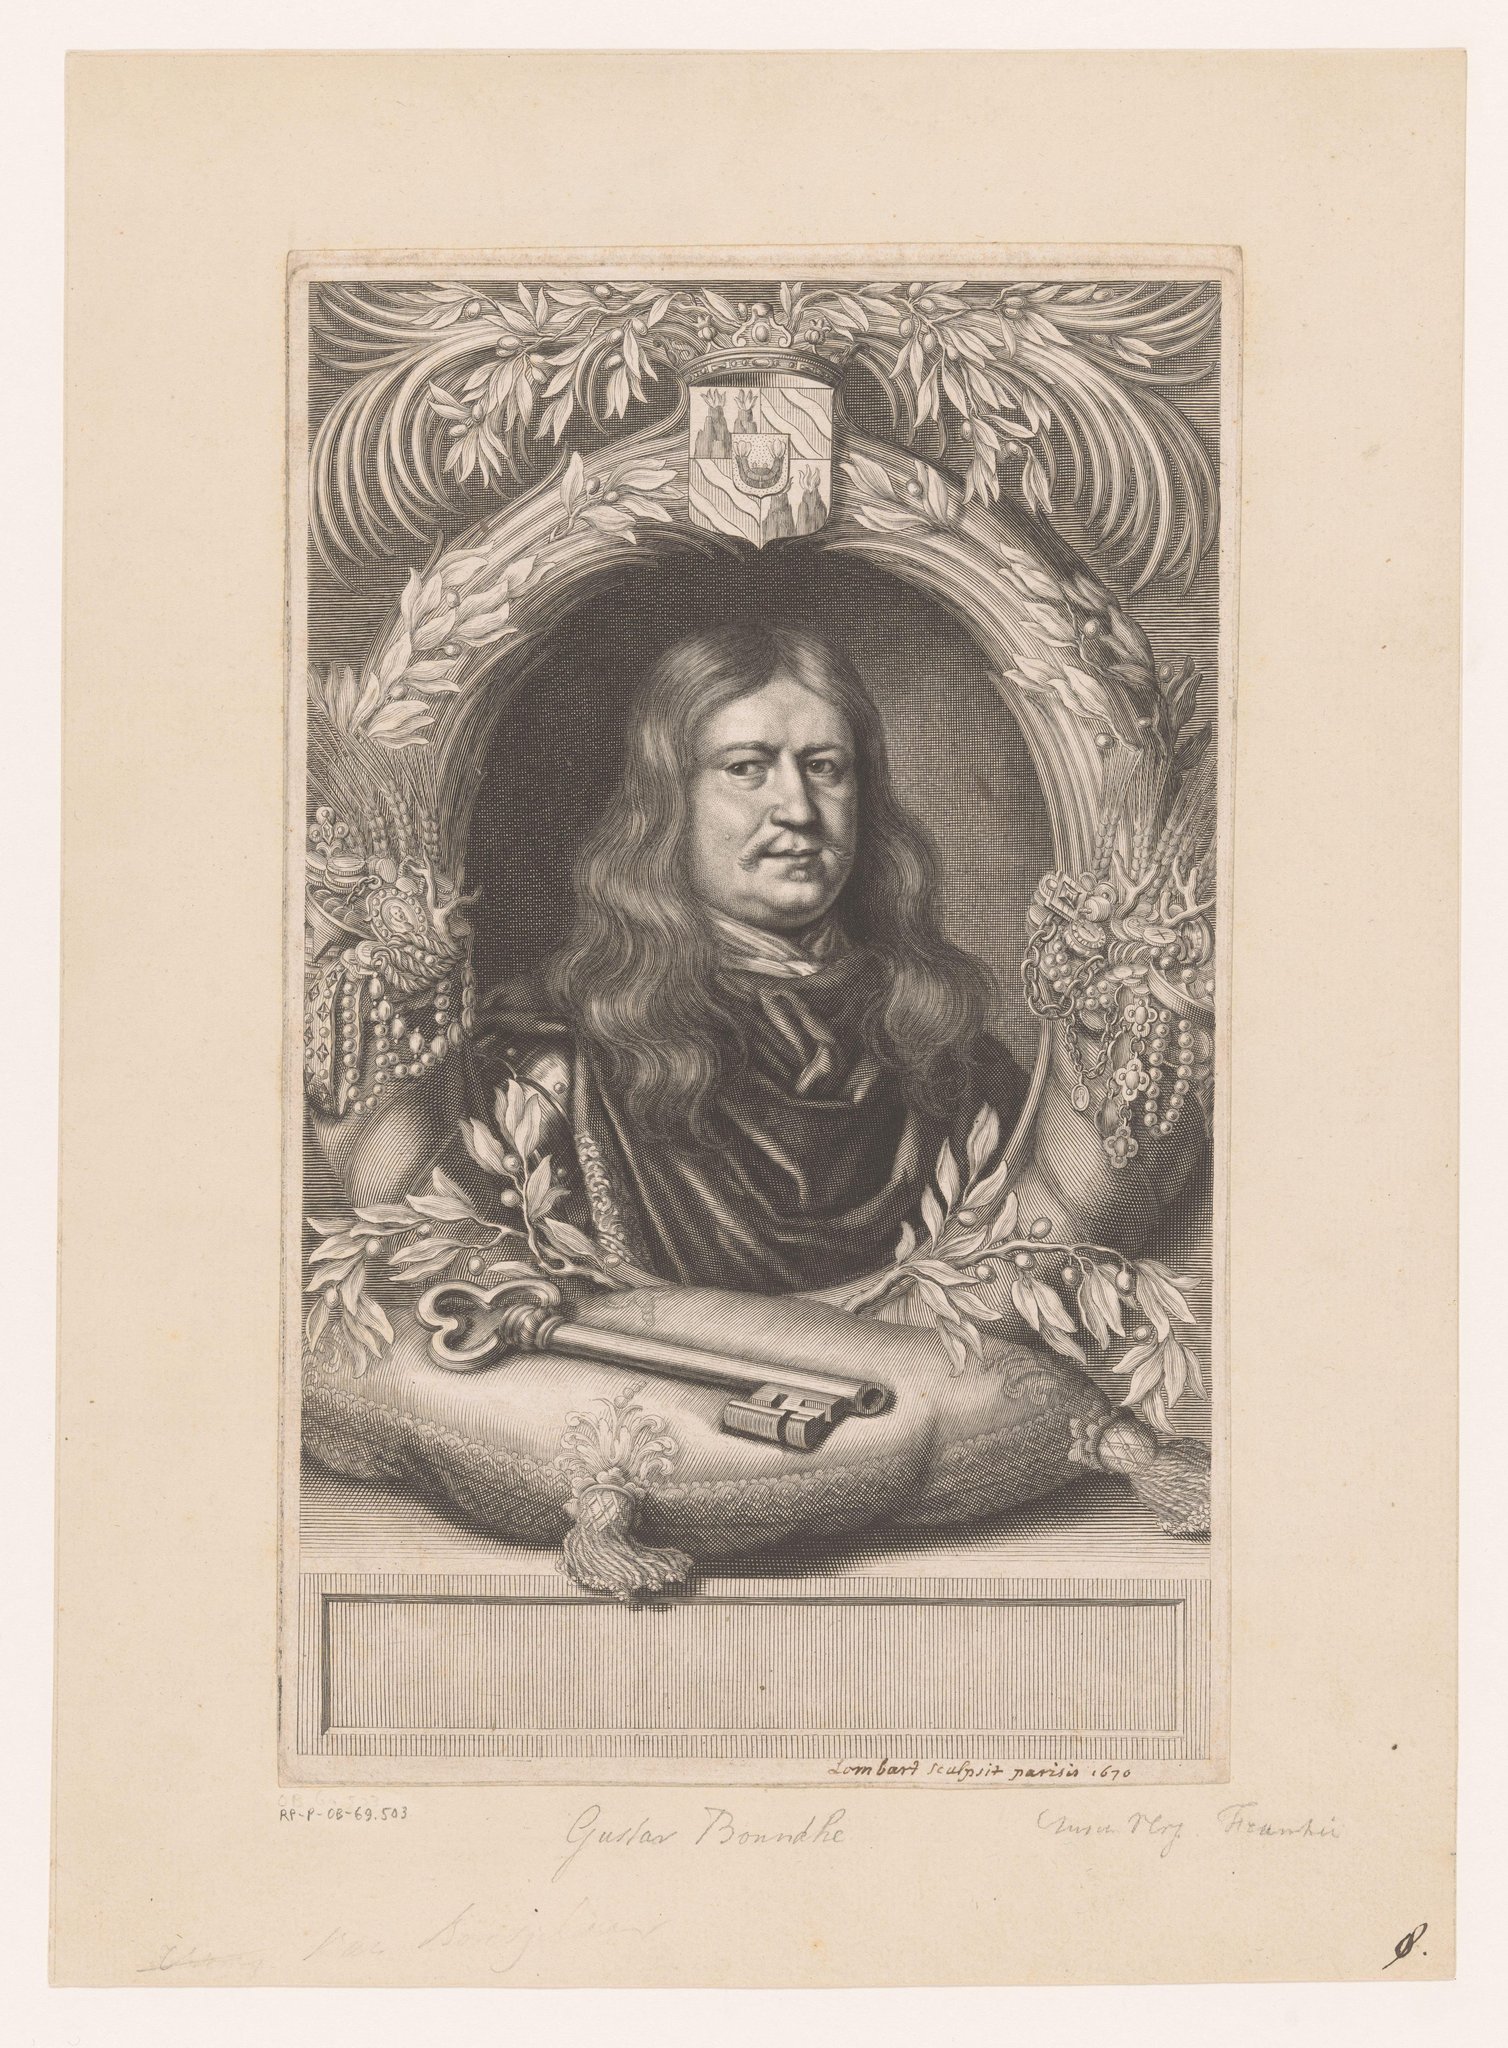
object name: print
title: Portret van Gustaf Bonde in versierde lijst met sleutel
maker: pierre lombard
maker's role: draughtsman, print maker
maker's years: 1612-1682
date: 1670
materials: paper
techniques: engraving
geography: paris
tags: official; civil servant; functionary (in general), historical persons, key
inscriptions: inscription: ‘Lombart sculpsit parisis 1670’